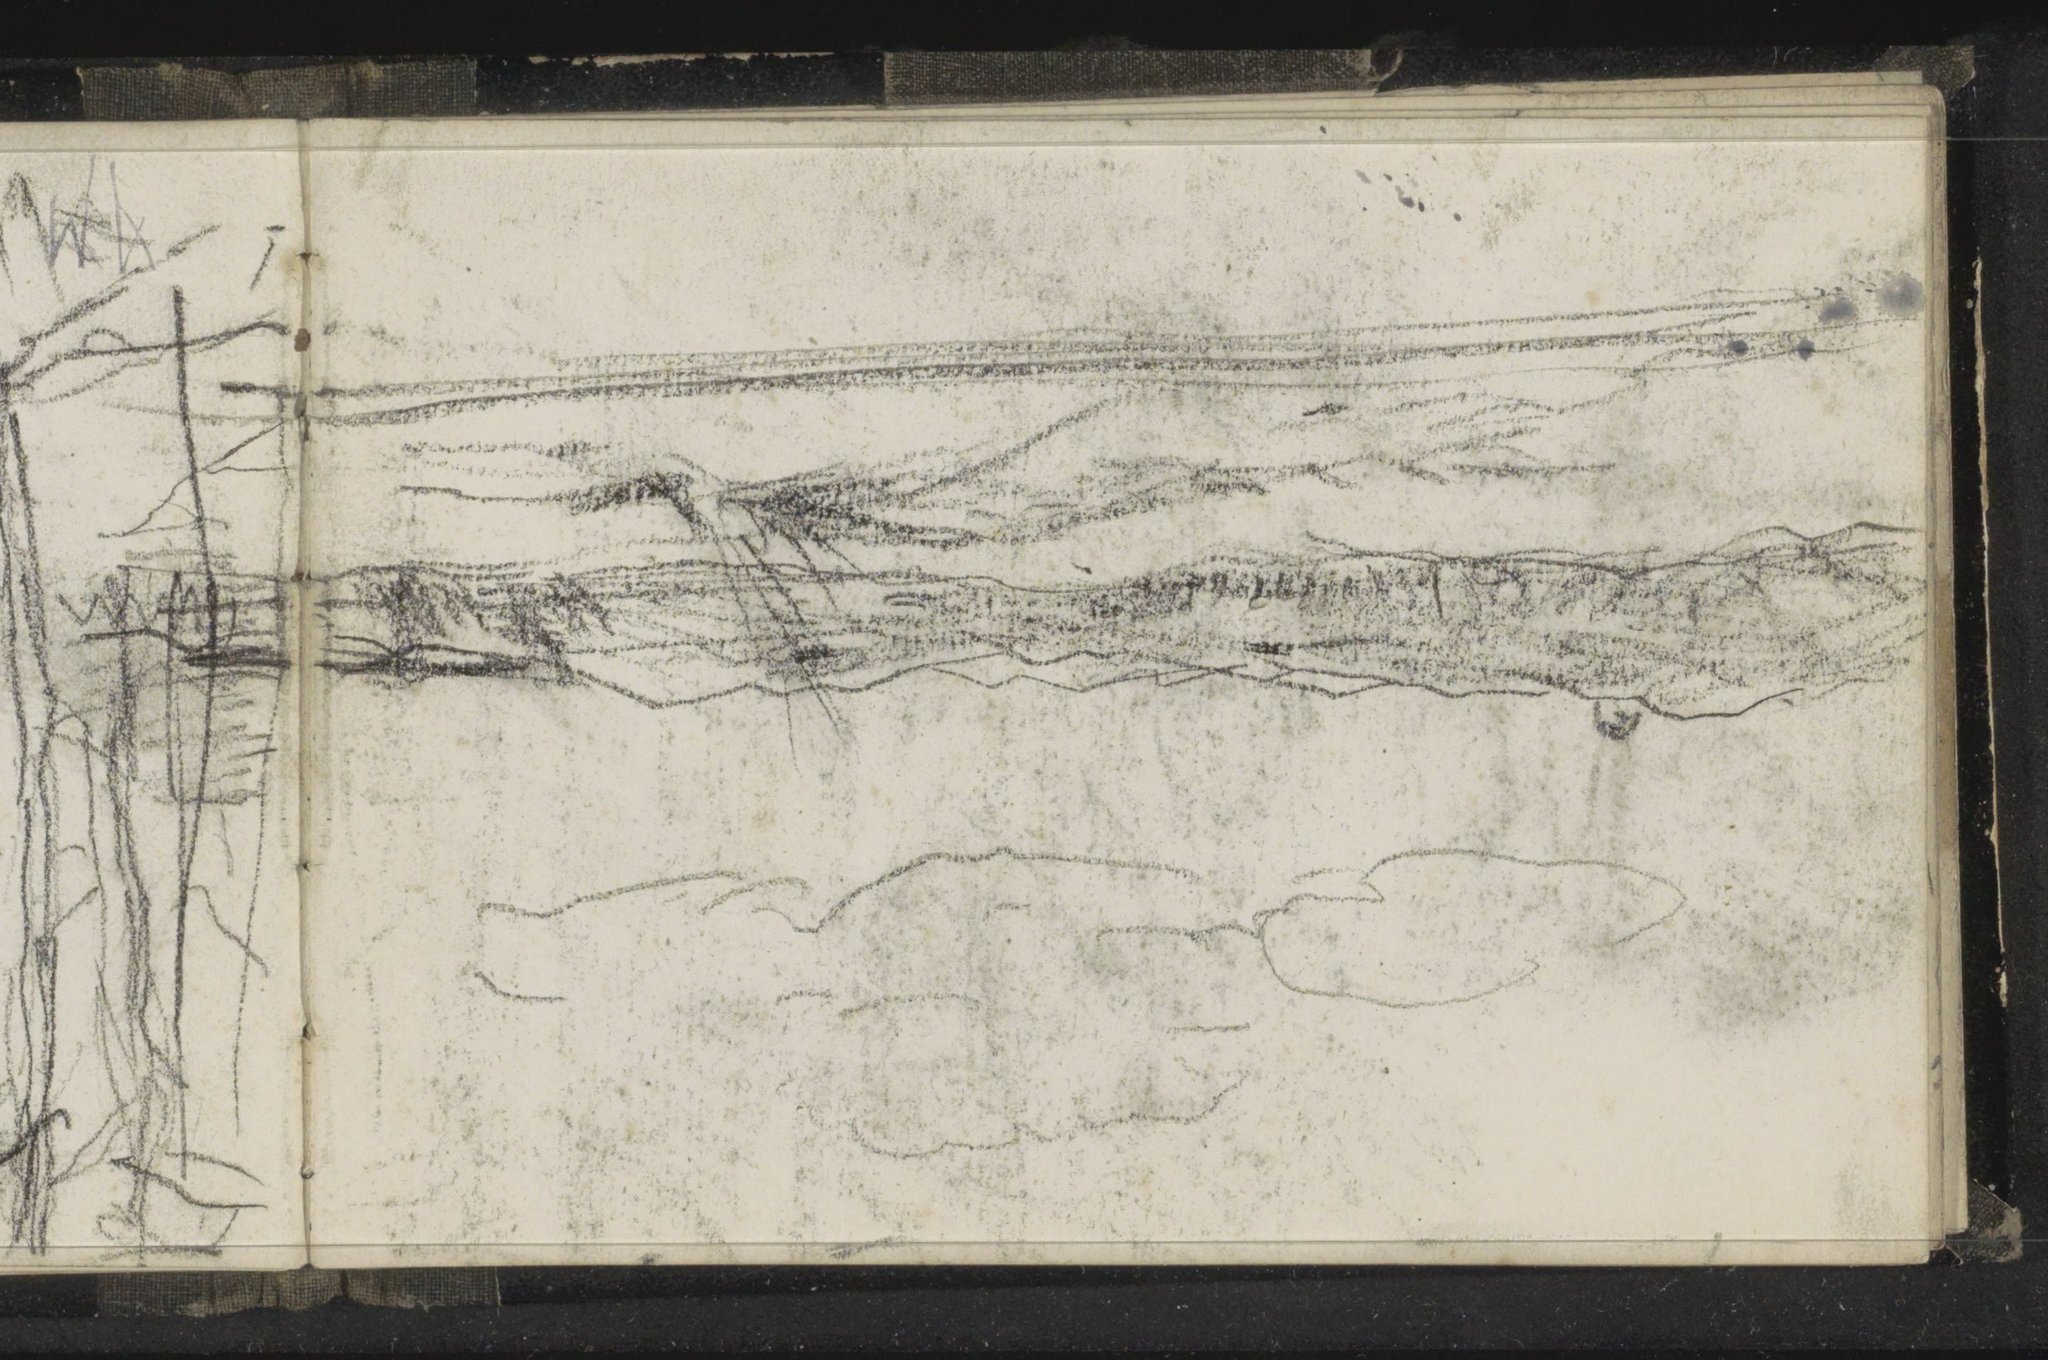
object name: sketchbook leaf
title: Heuvellandschap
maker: anton mauve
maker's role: draughtsman, painter, print maker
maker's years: 1838-1888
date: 1848-1888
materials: chalk, paper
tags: low hill country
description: Blad 16 recto uit een schetsboek met 33 bladen.